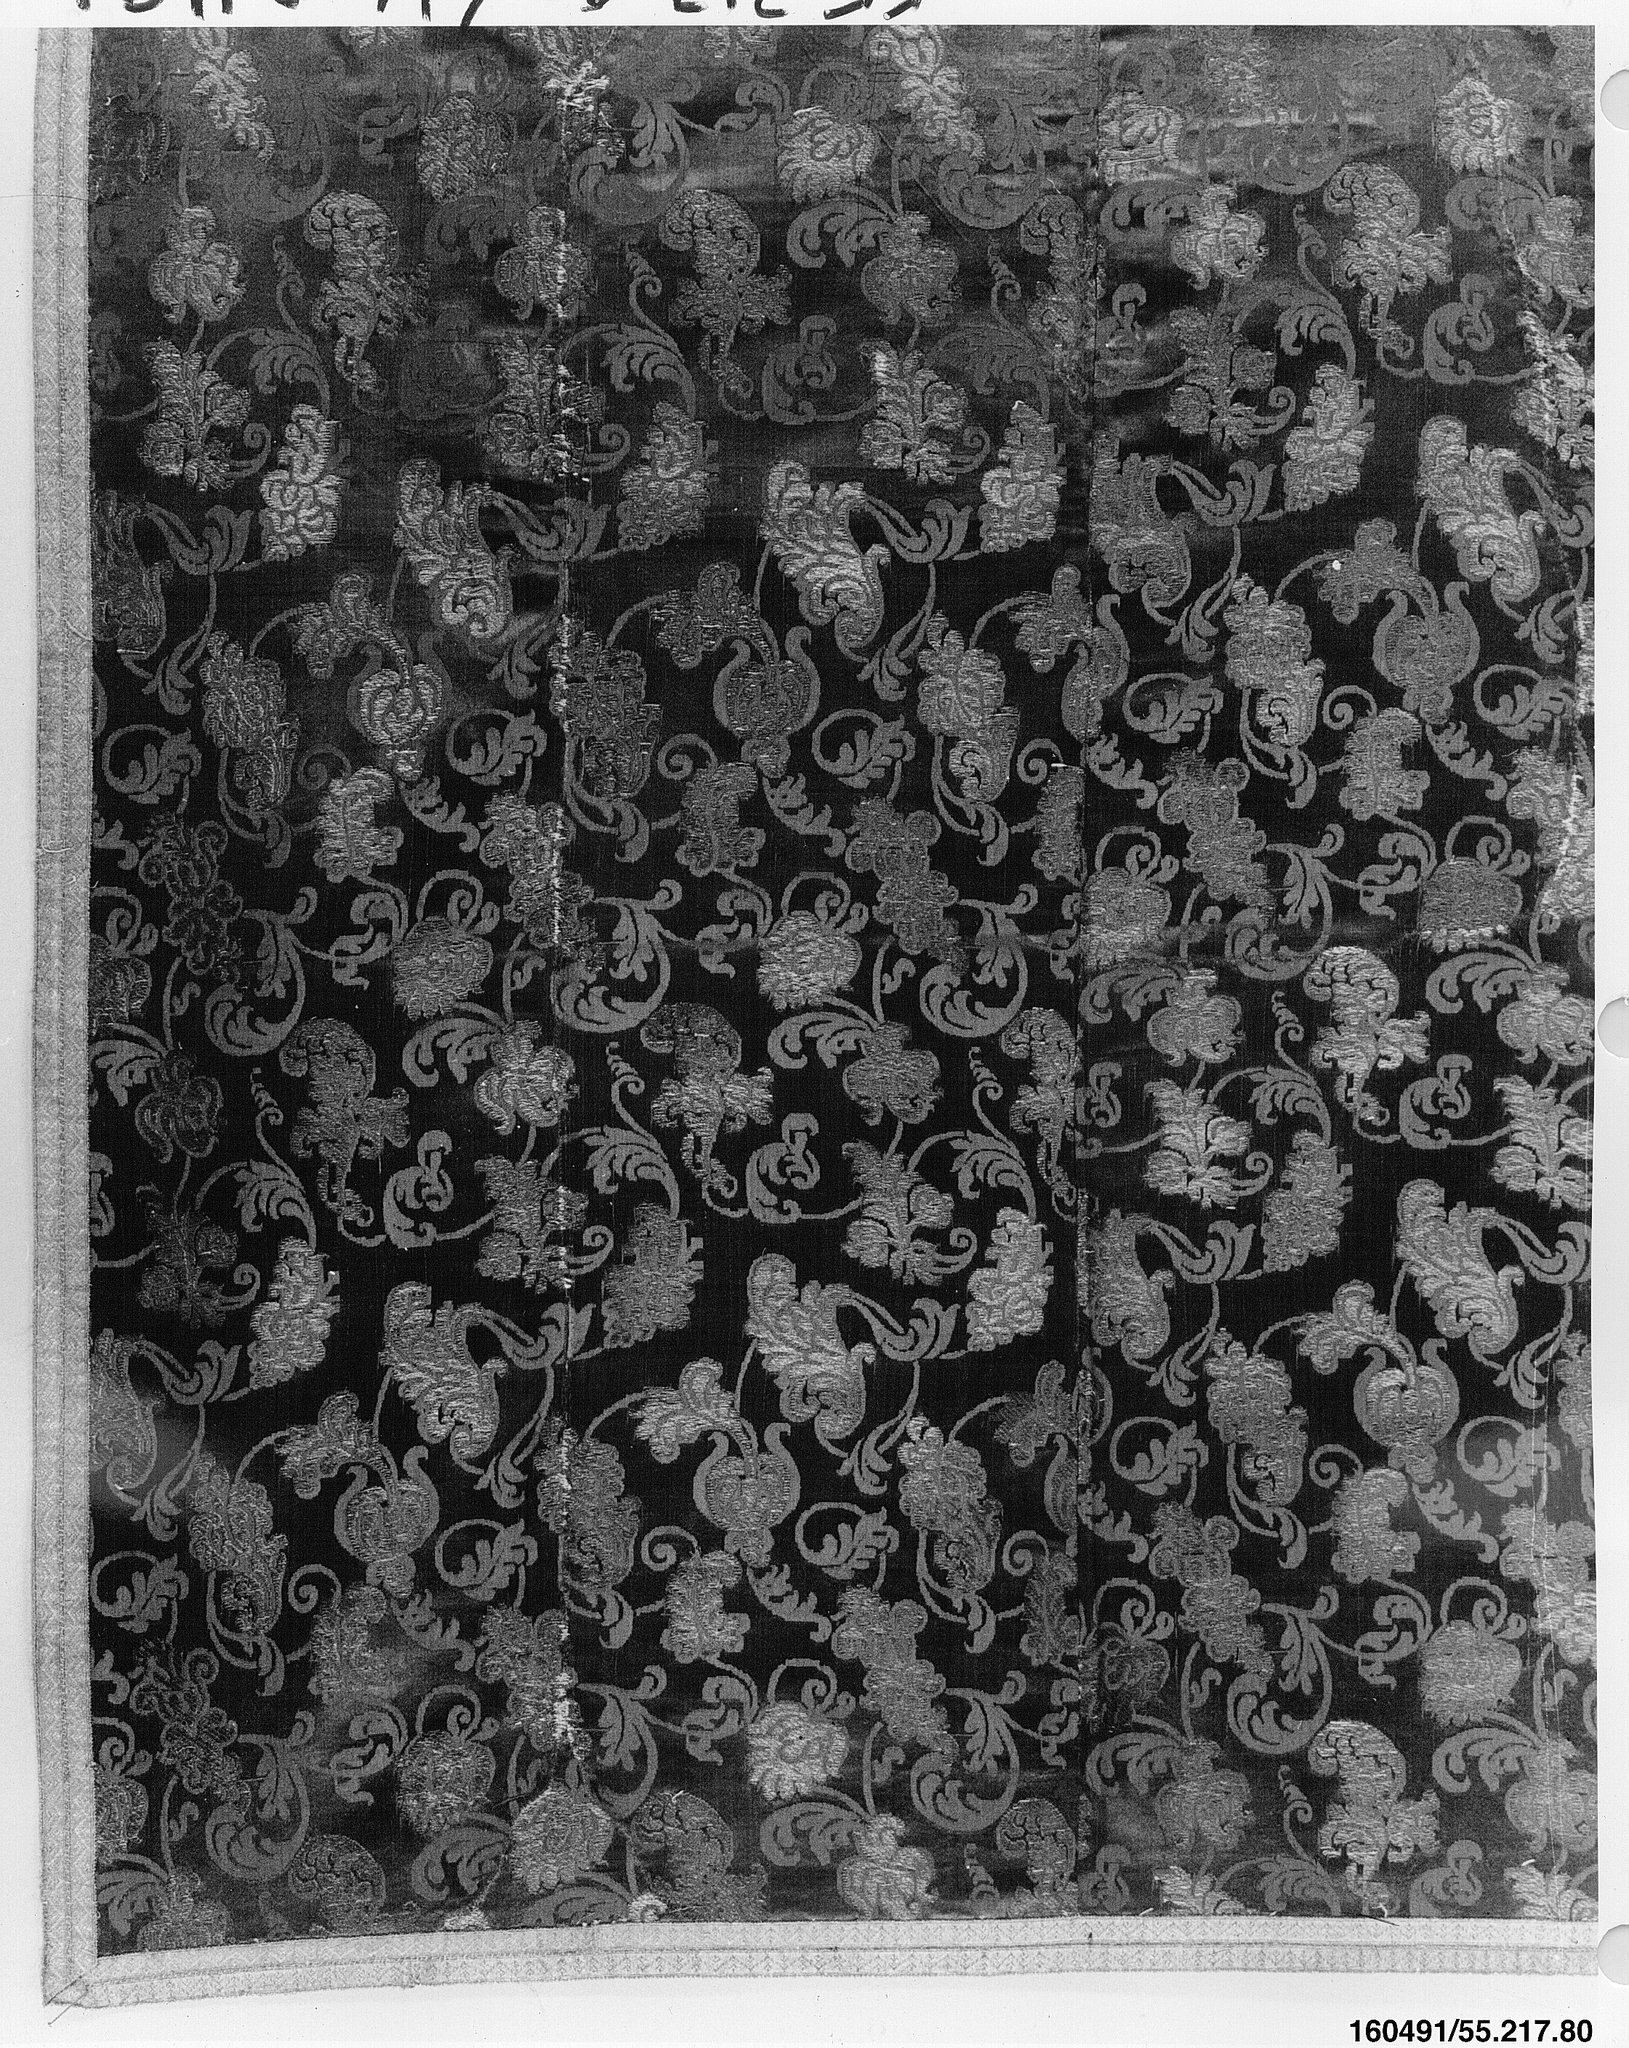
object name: piece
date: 1695-1700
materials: metal thread, silk